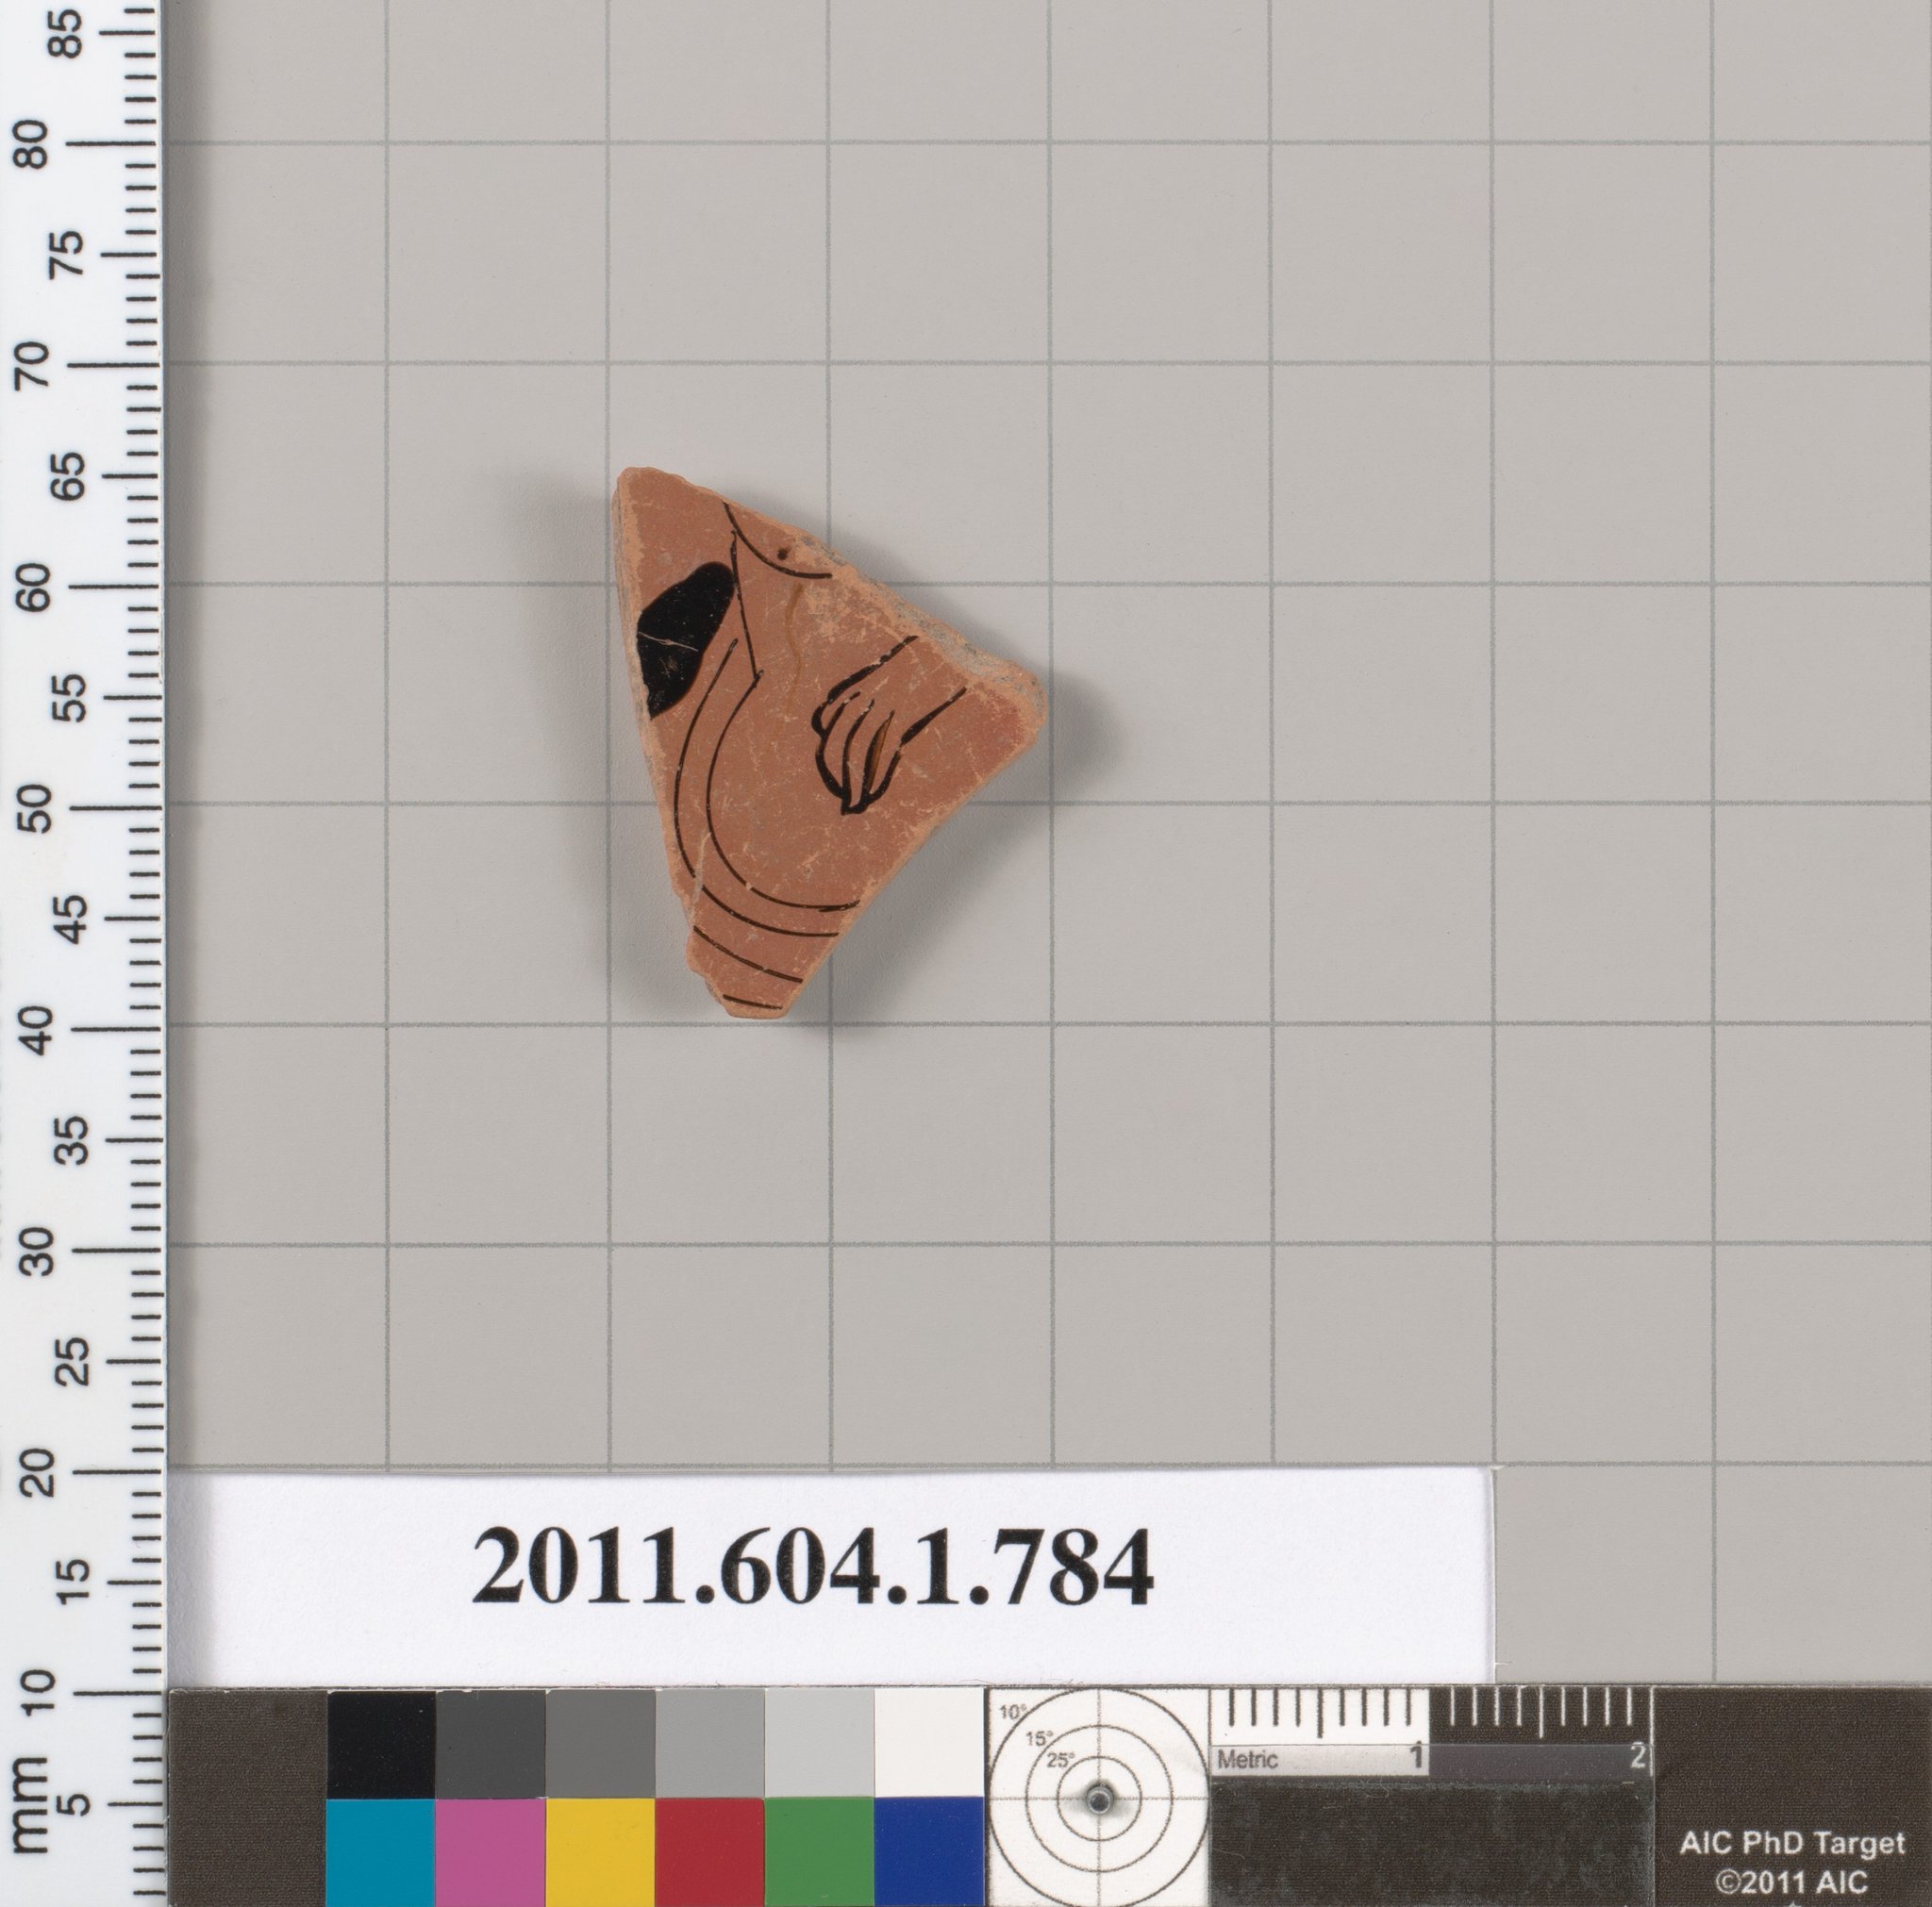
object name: kylix fragment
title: Terracotta fragment of a kylix (drinking cup)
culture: greek, attic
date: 475-451 BCE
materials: terracotta